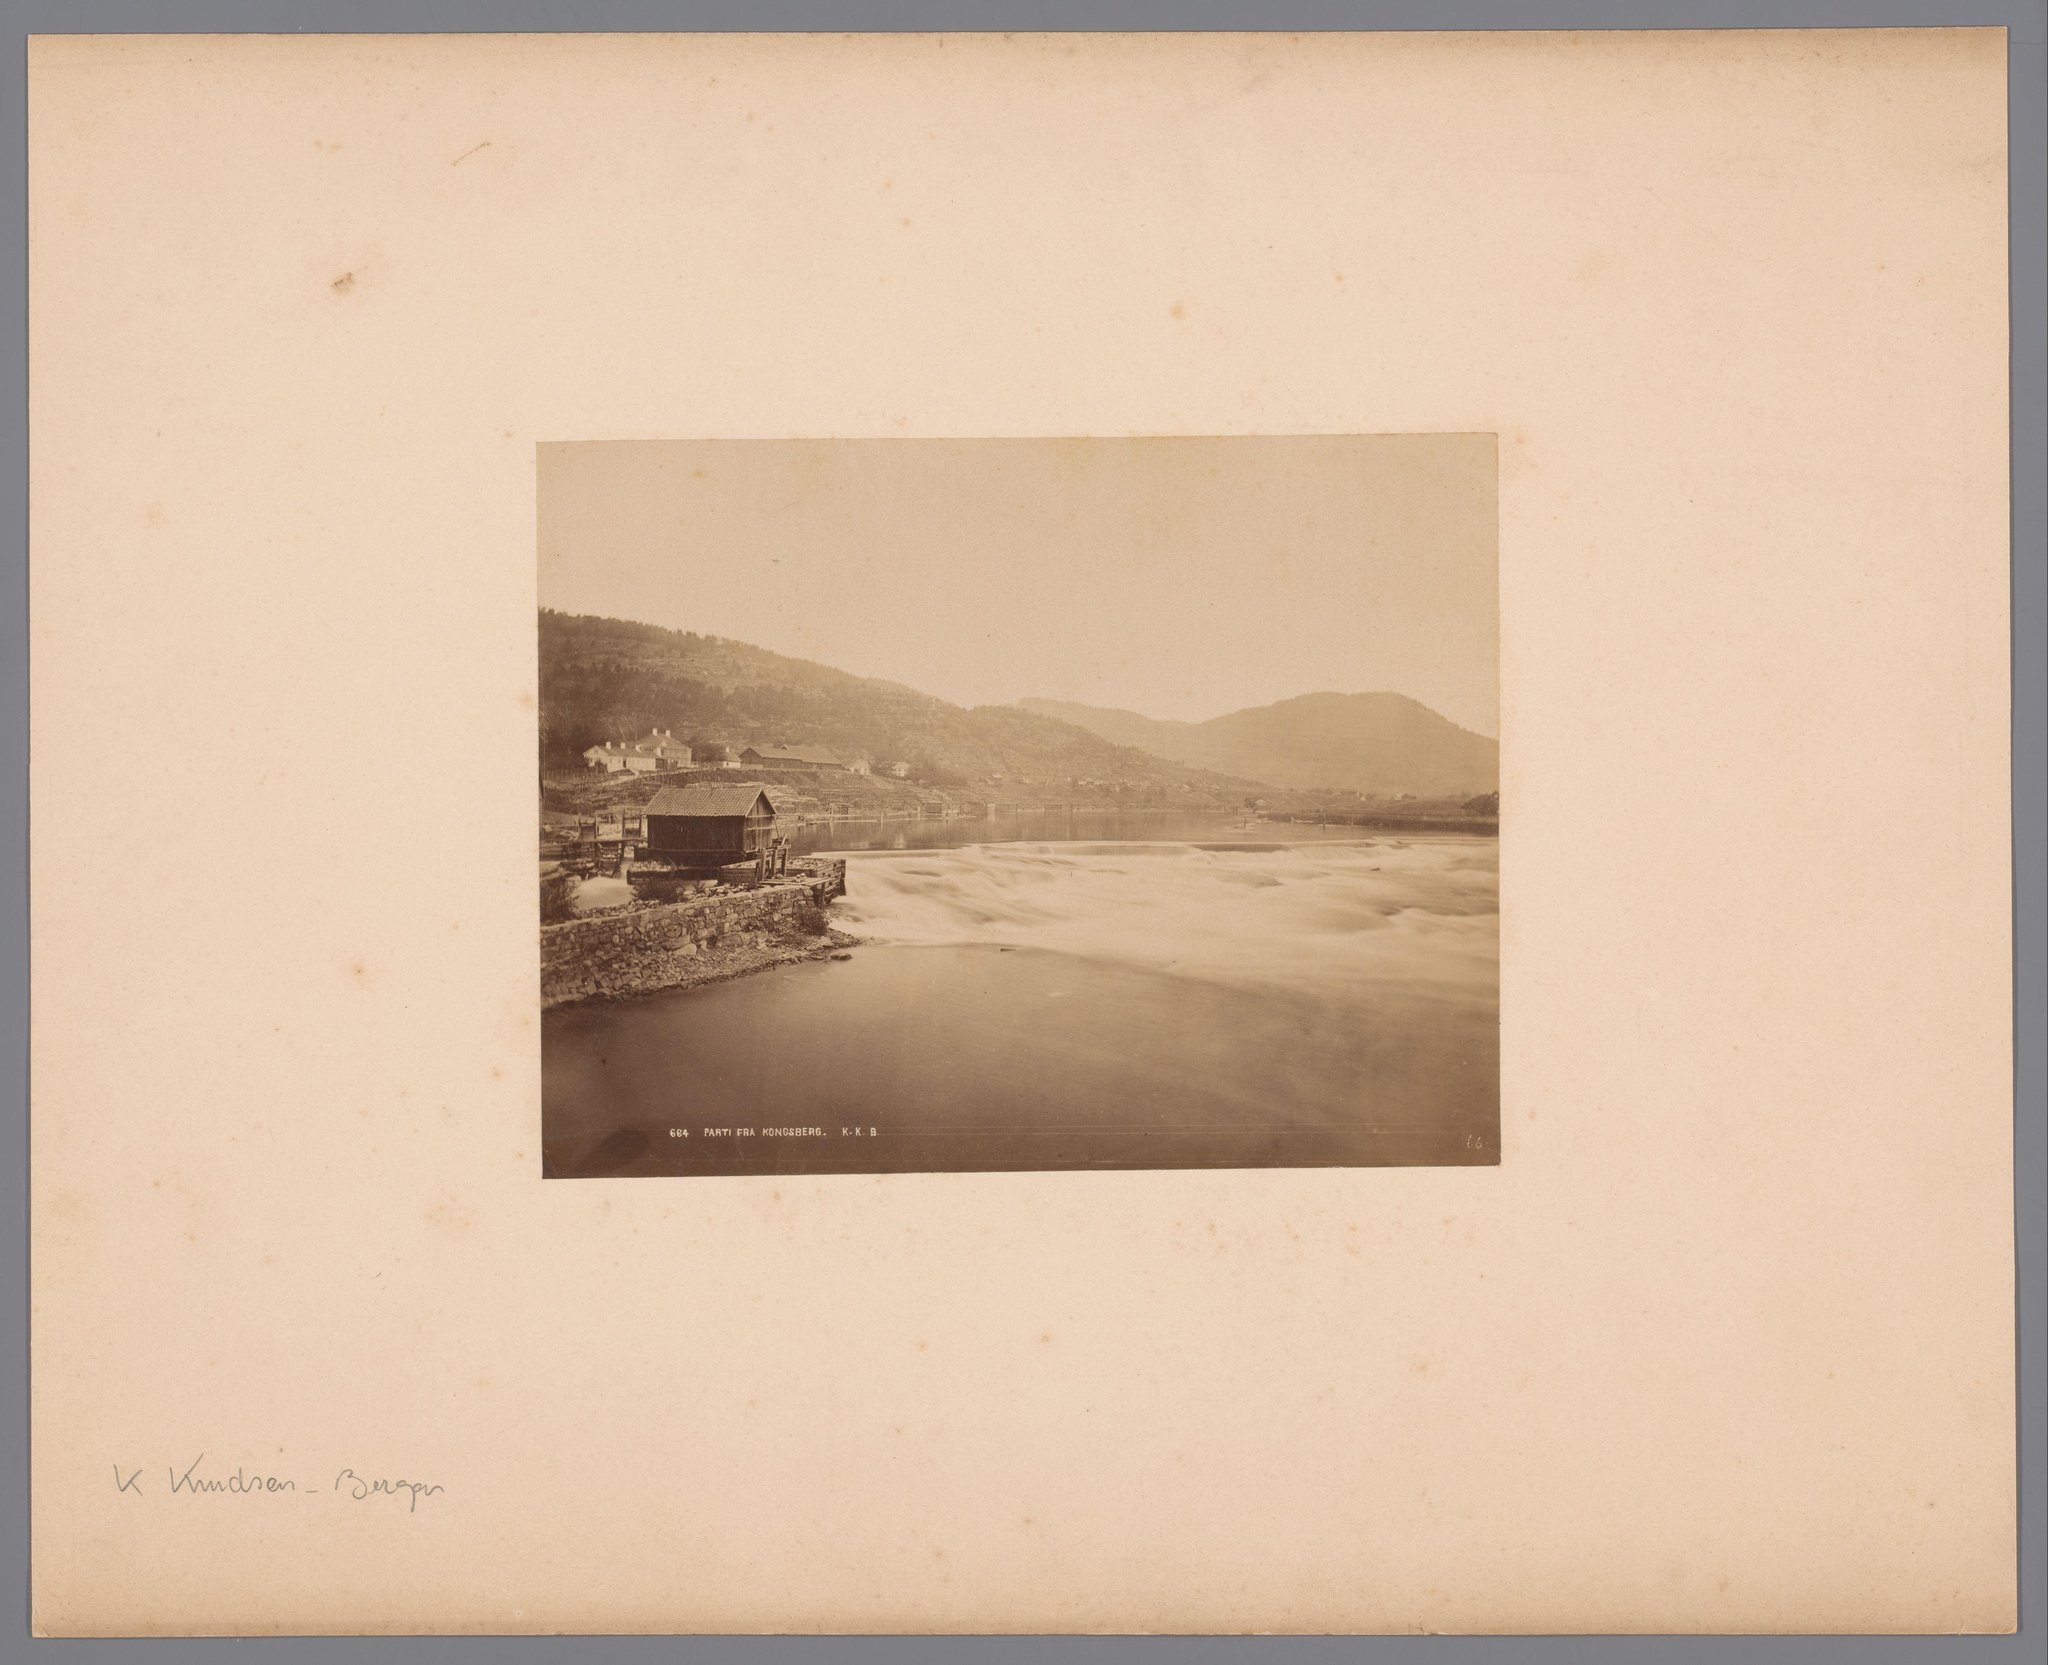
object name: photograph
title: Parti fra Kongsberg (=Koningsberg), Noorwegen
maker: knud knudsen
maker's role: fotograaf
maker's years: 1832-1915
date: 1870-1900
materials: cardboard, photographic support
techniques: albumen print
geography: norway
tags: norway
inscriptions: caption: ‘664. PARTI FRA KONGSBERG.’, signature: ‘K.K.B.’, caption: ‘K. Knudsen - Bergen’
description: Groot meer, met een kleine waterval en eromheen bergen. Kongsberg (Koningsberg), is een stad in Noorwegen, gelegen in de provincie Buskerud, ongeveer 80 km ten westen van de hoofdstad Oslo.